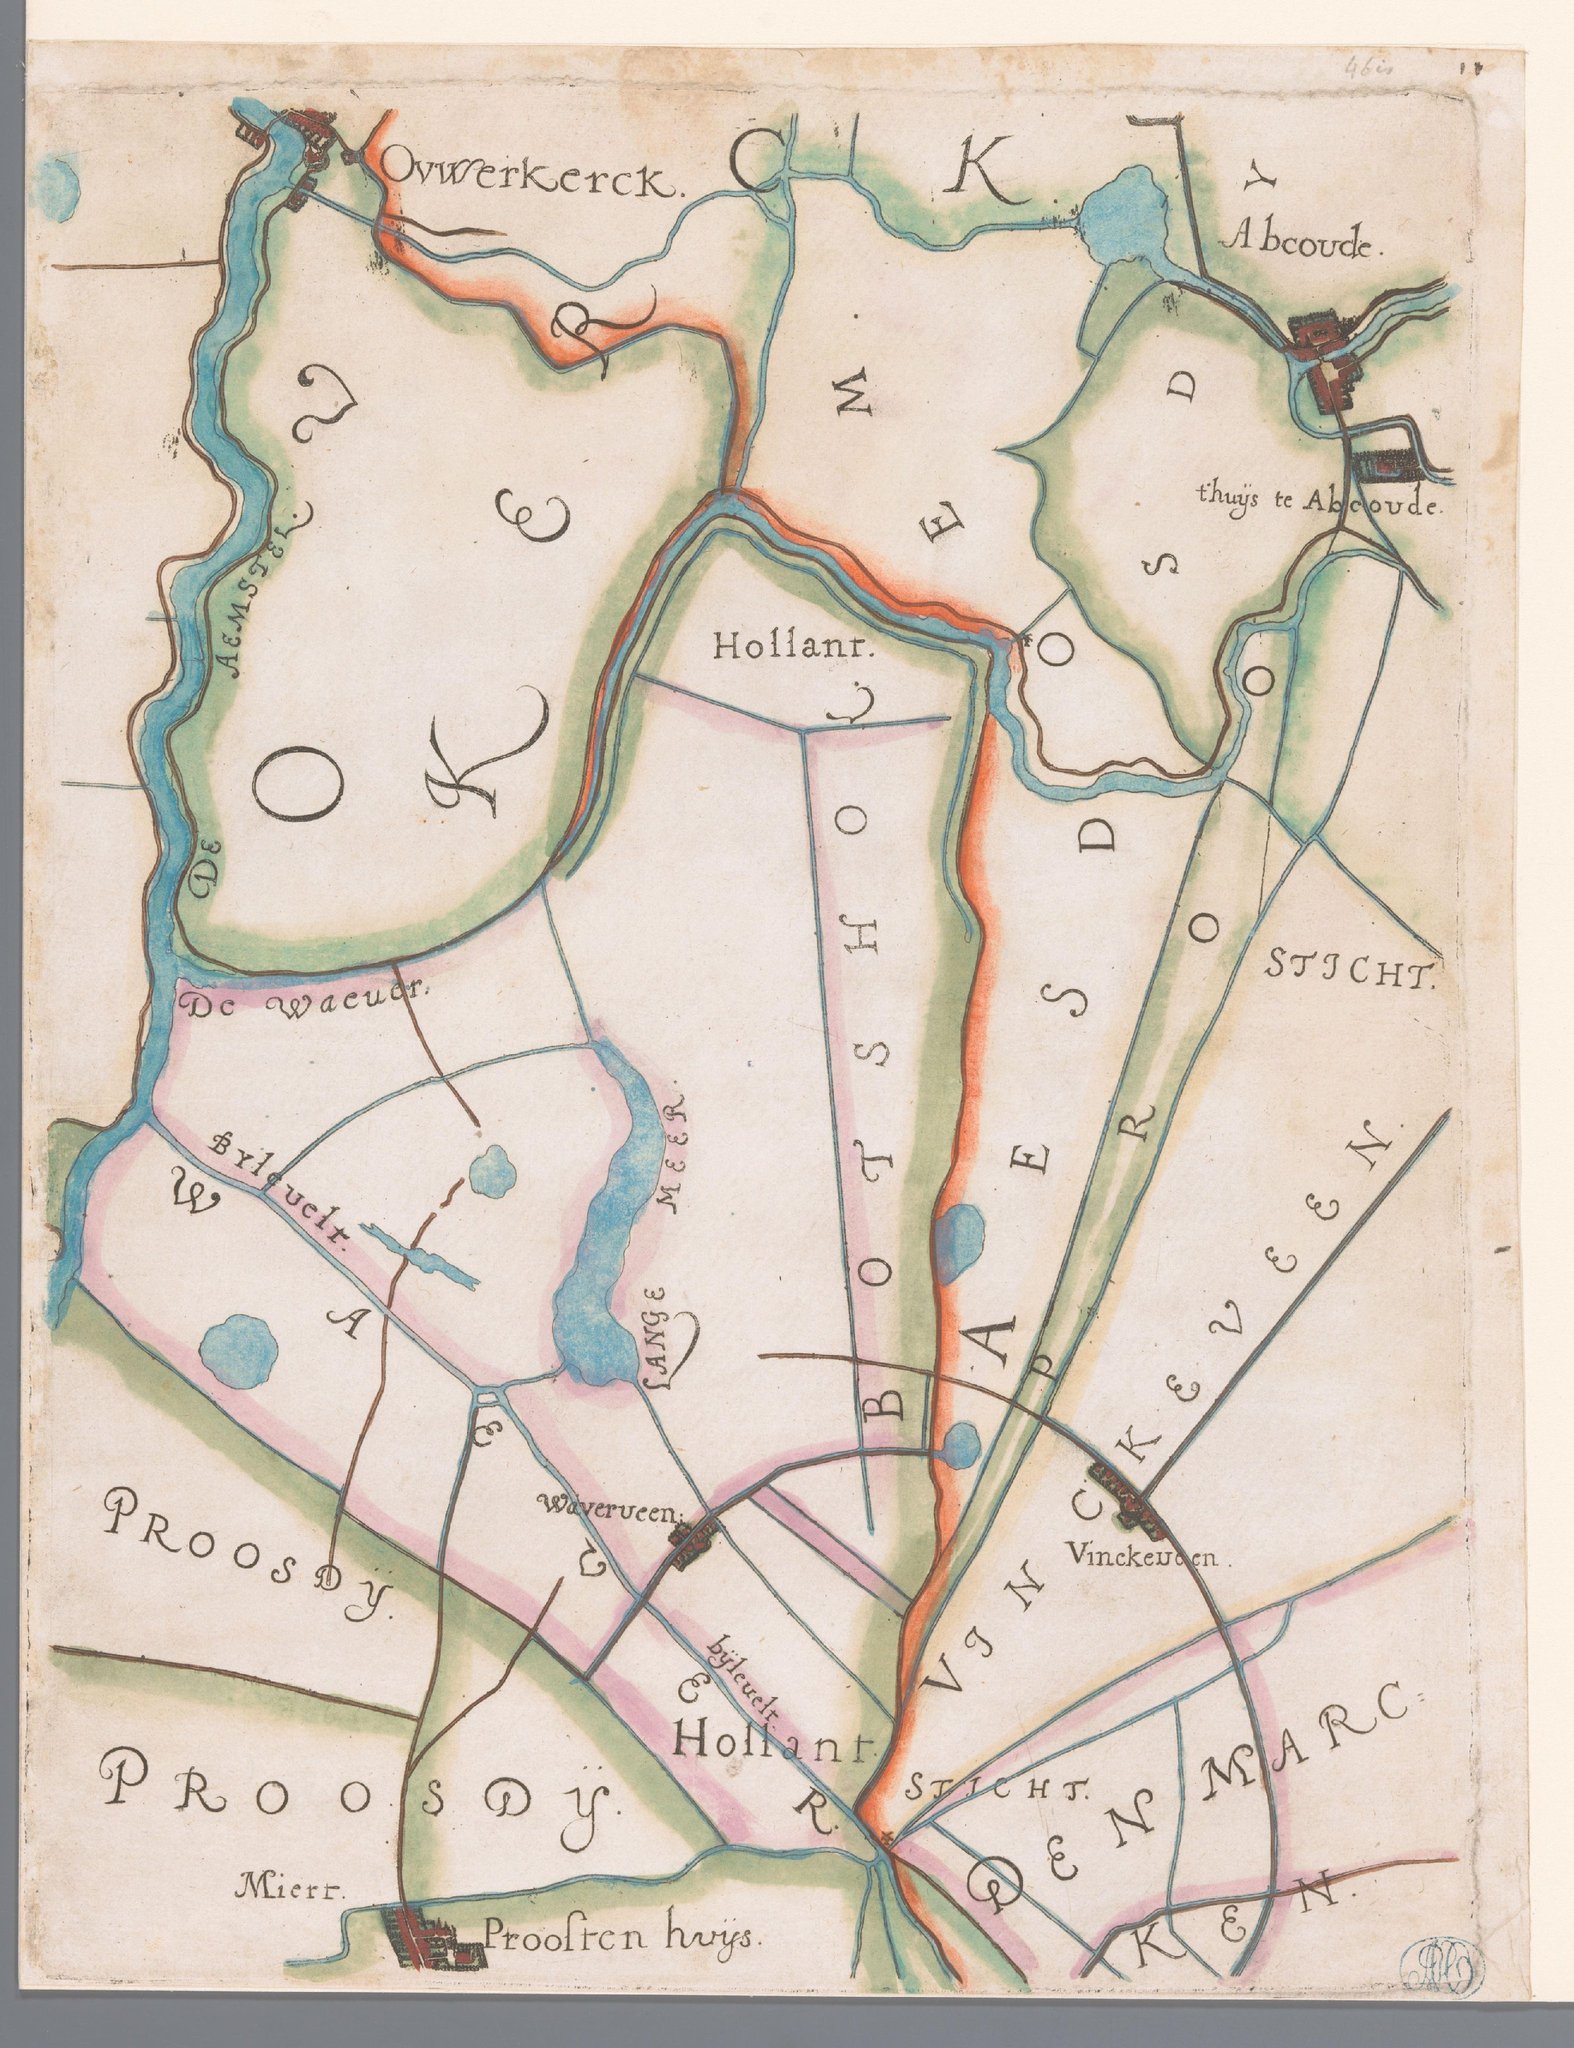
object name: print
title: Deel van een kaart van het Hoogheemraadschap van Rijnland, met Abcoude en Vinkeveen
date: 1615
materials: paper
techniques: engraving, etching, hand coloring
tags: maps of separate countries or regions, abcoude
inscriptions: collector's mark: Lugt 195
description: Deel van een kaart van Rijnland, bestaande uit 27 delen.